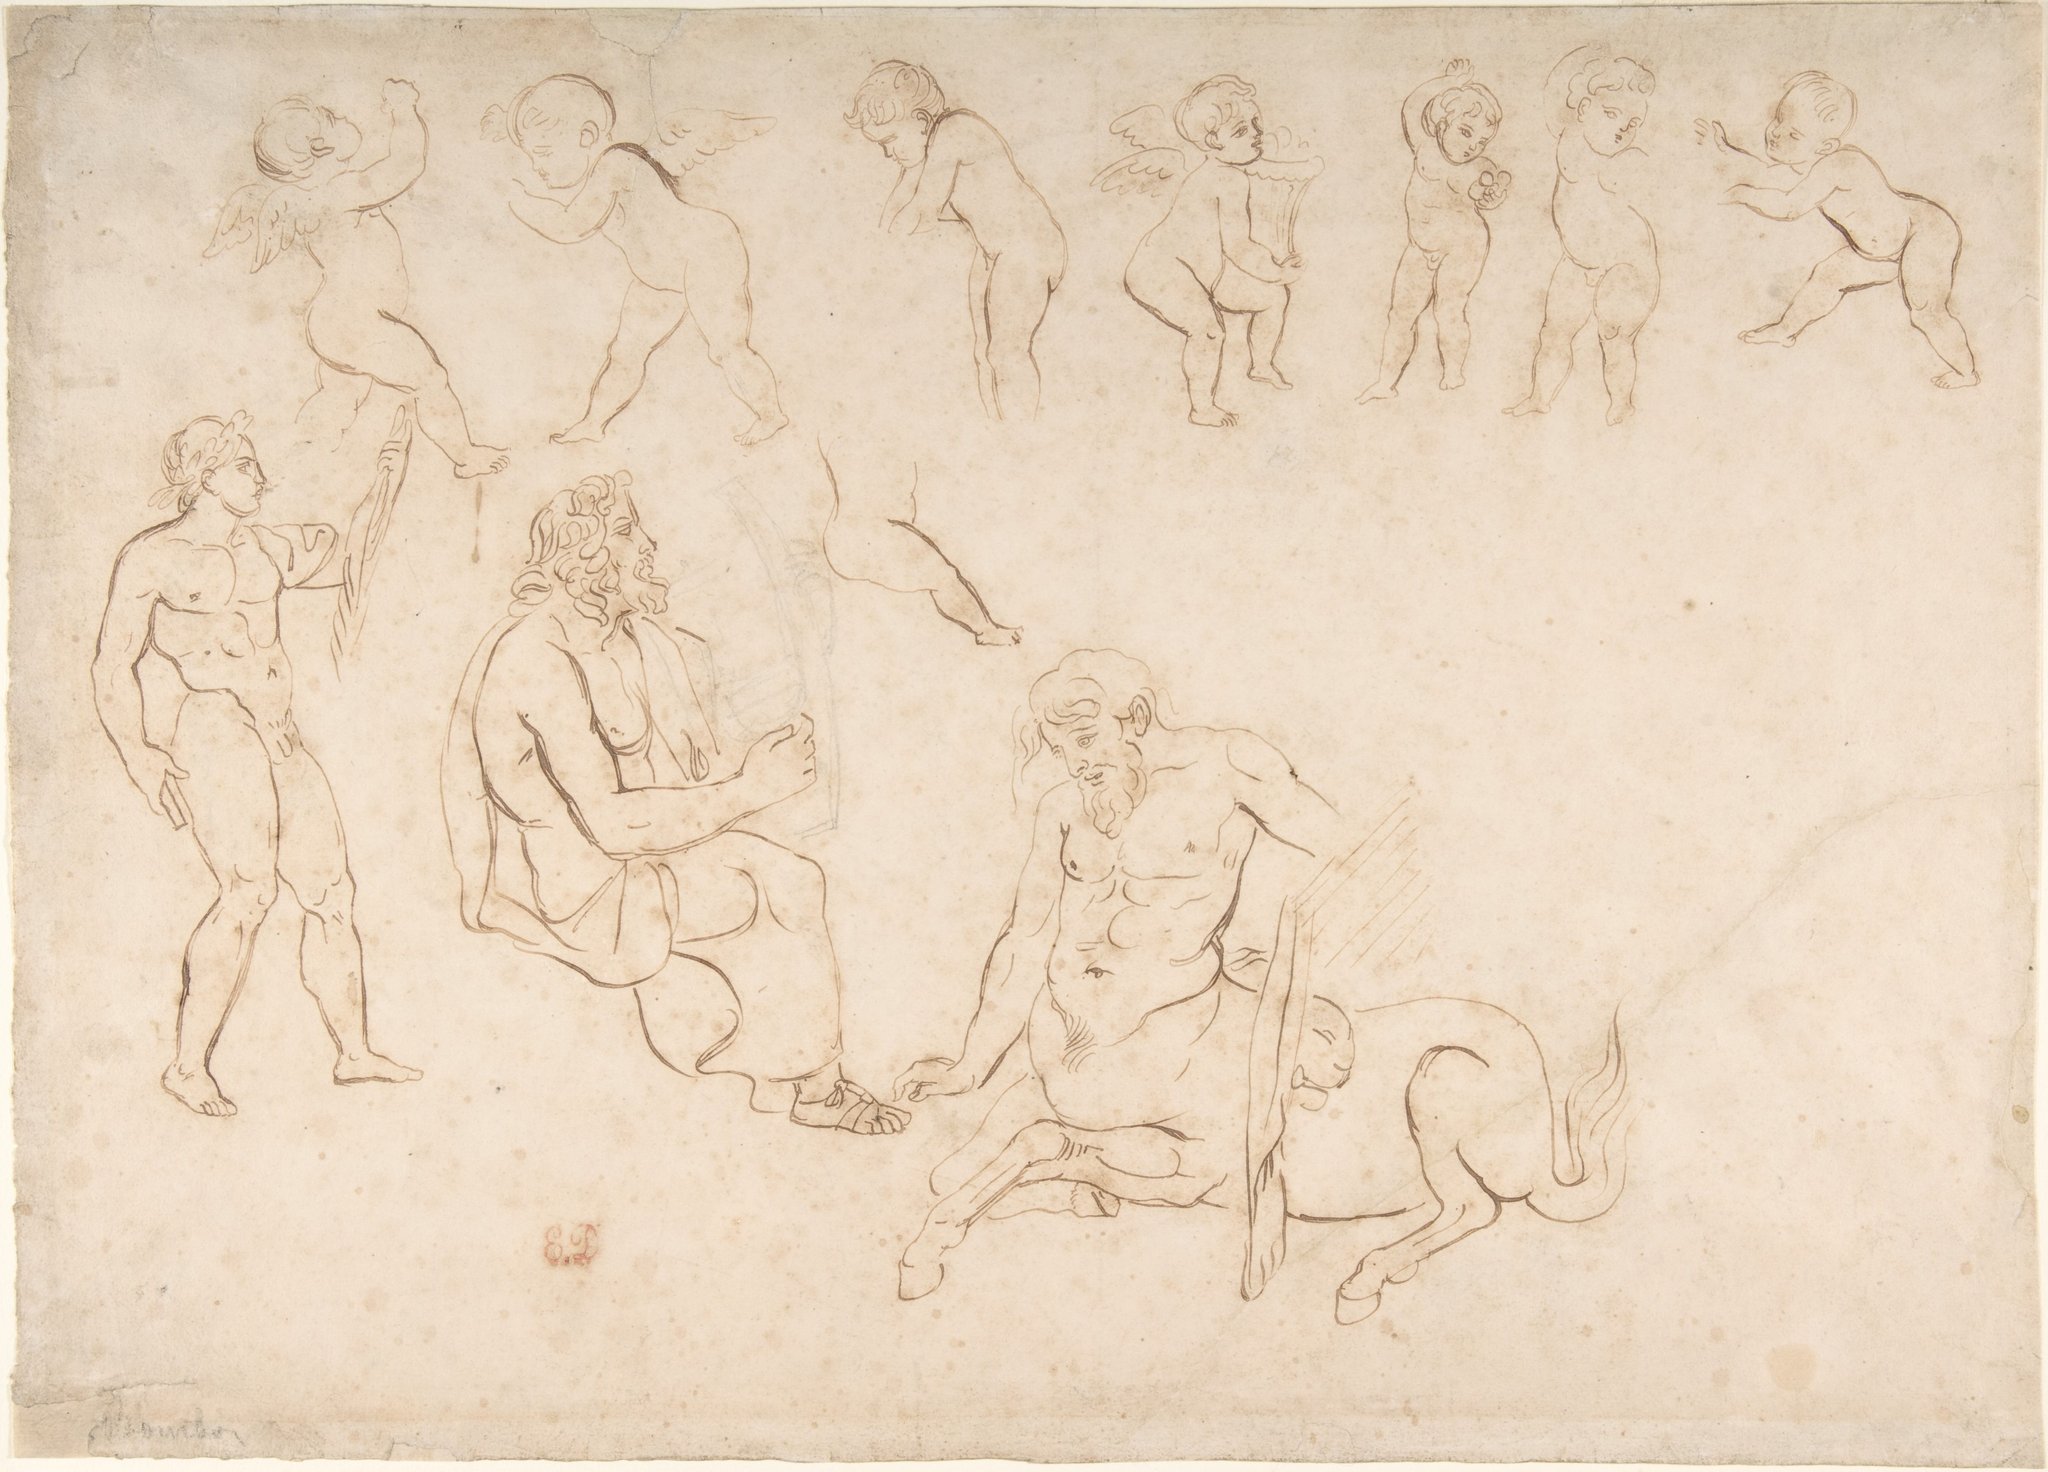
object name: drawing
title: Studies for the decoration of the Library, Palais Bourbon, Paris: standing nude athlete; seated man with a lyre; centaur; and seven putti (three with wings)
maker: eugène delacroix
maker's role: artist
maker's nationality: french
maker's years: 1798-1863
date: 1798-1863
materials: graphite, ink, paper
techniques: pen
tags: male nudes,centaurs,putti